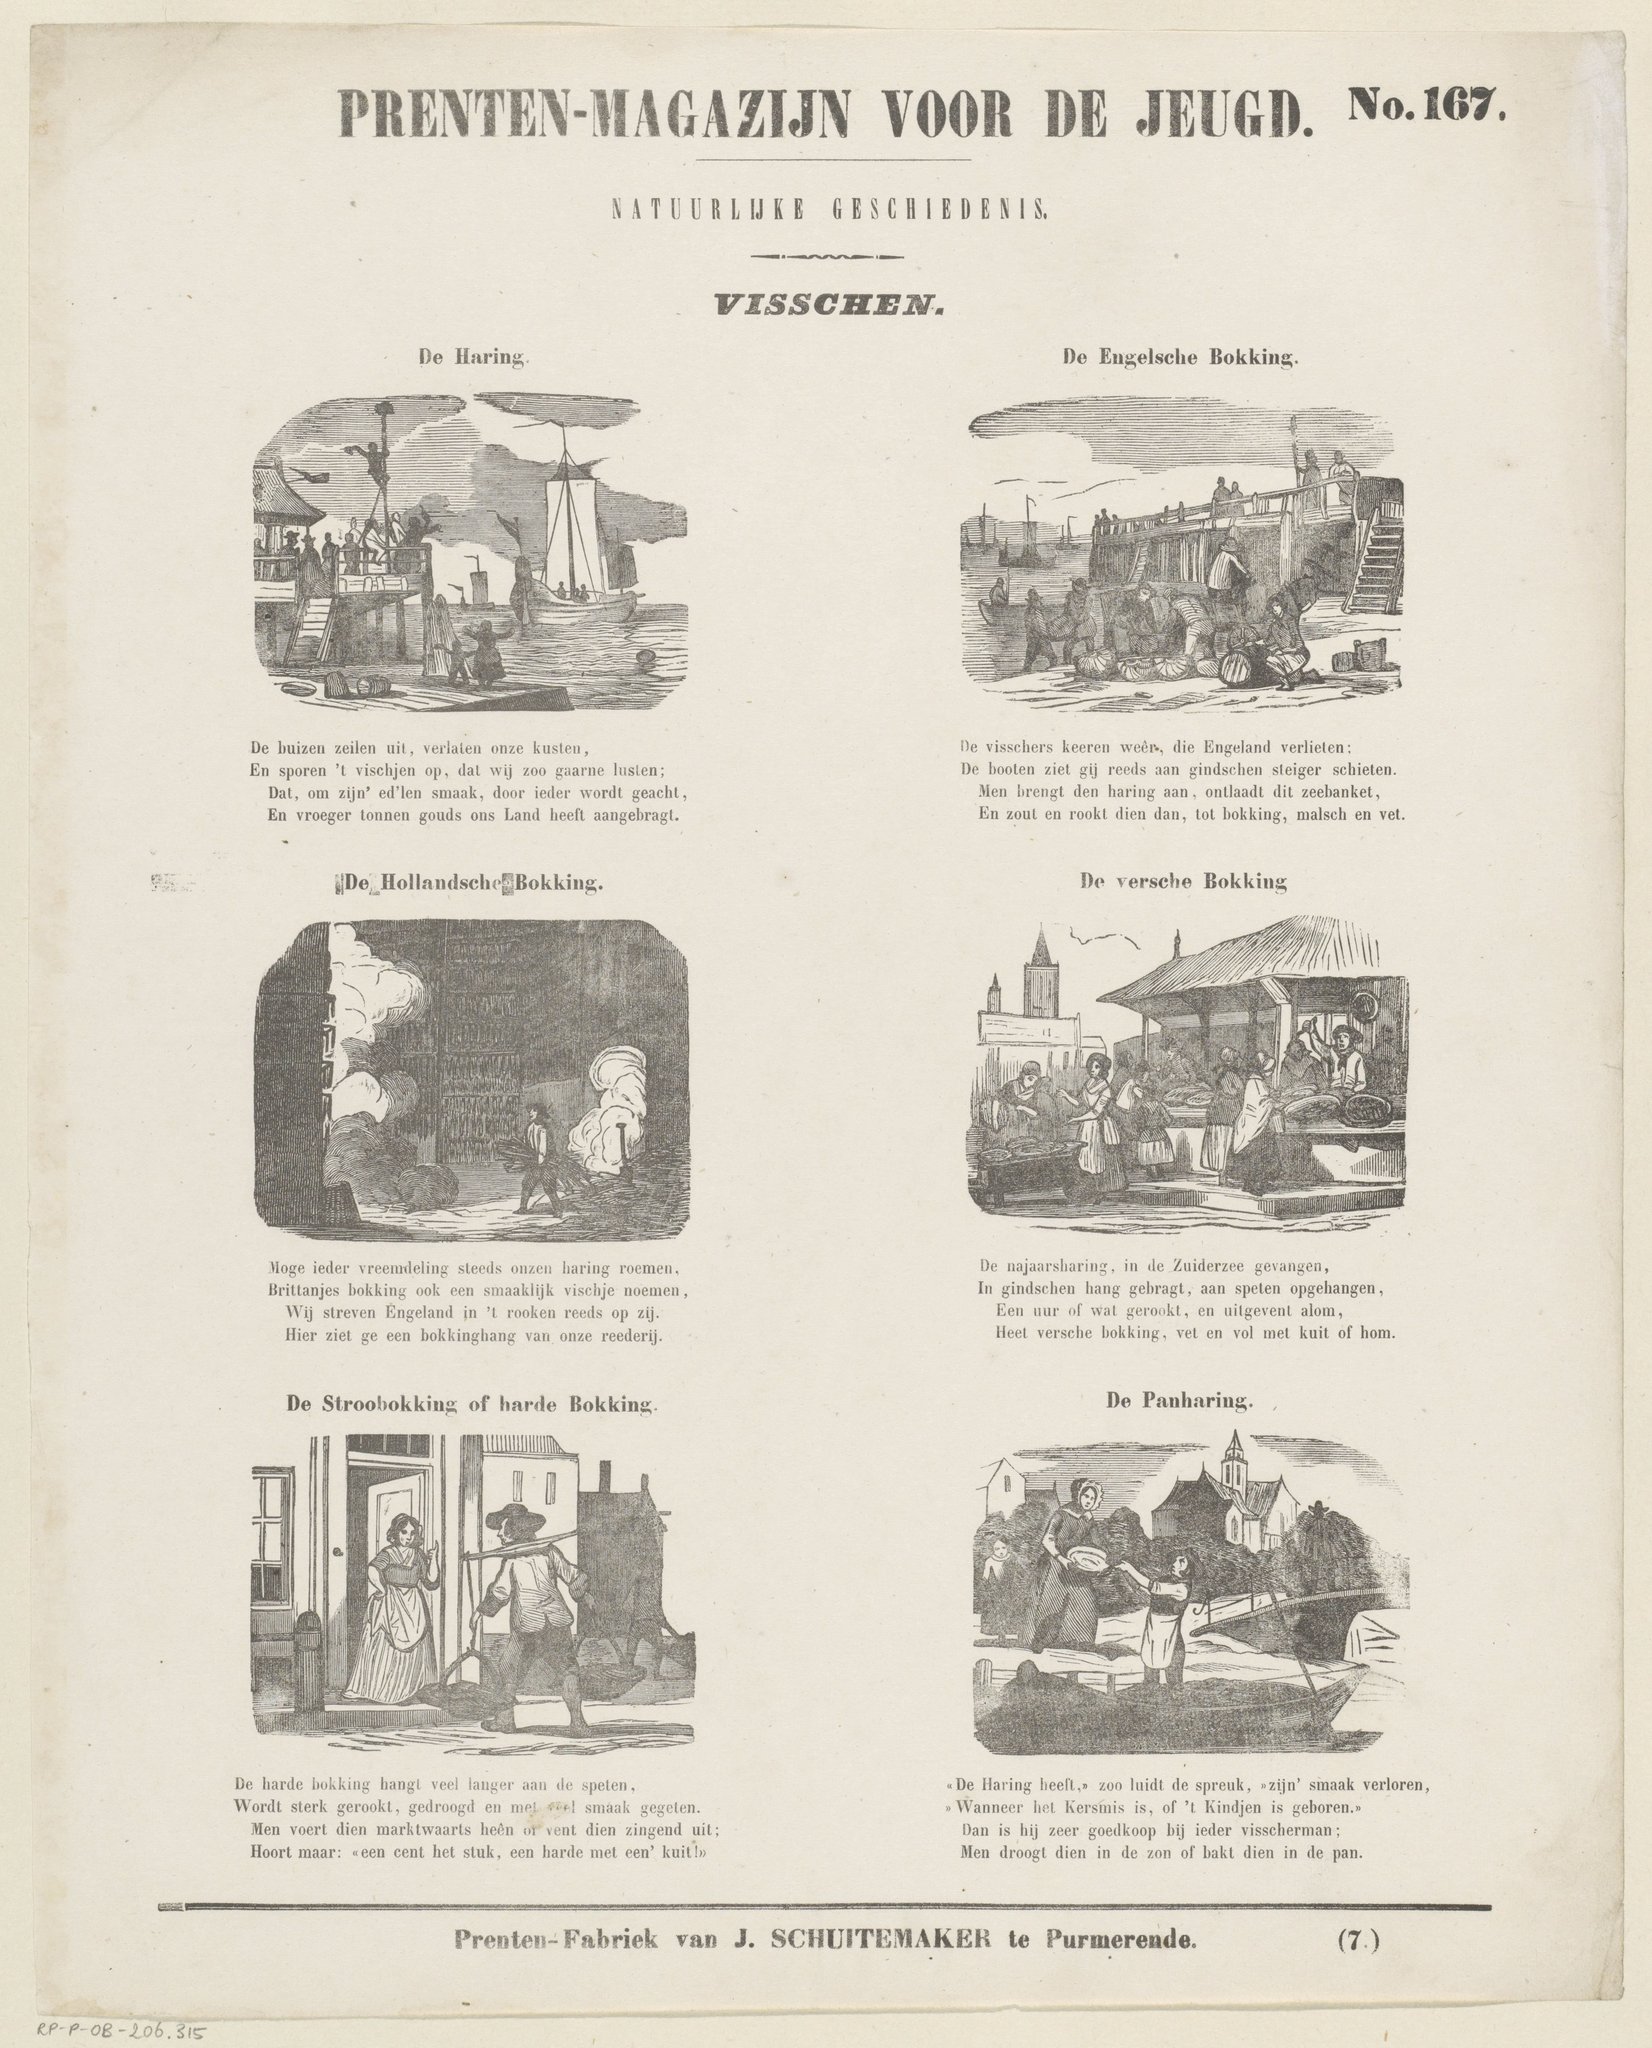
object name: print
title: Natuurlijke geschiedenis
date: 1850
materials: paper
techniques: letterpress printing, engraving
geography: netherlands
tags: commercial fishery, street-trader, merchant, salesman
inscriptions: collector's mark: Lugt 2760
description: Na voltooiing van de acht jaargangen van de reeks 'Prenten-magazijn voor de jeugd' in 1850 heeft Jan Schuitemaker al deze prenten heruitgegeven en omgenummerd als nr. 1 t/m 192. De oorspronkelijke jaargang wordt telkens nog vermeld rechtsonder op de prent. Binnen de jaargangen zijn prenten van hetzelfde thema in clusters van vier achter elkaar gezet.